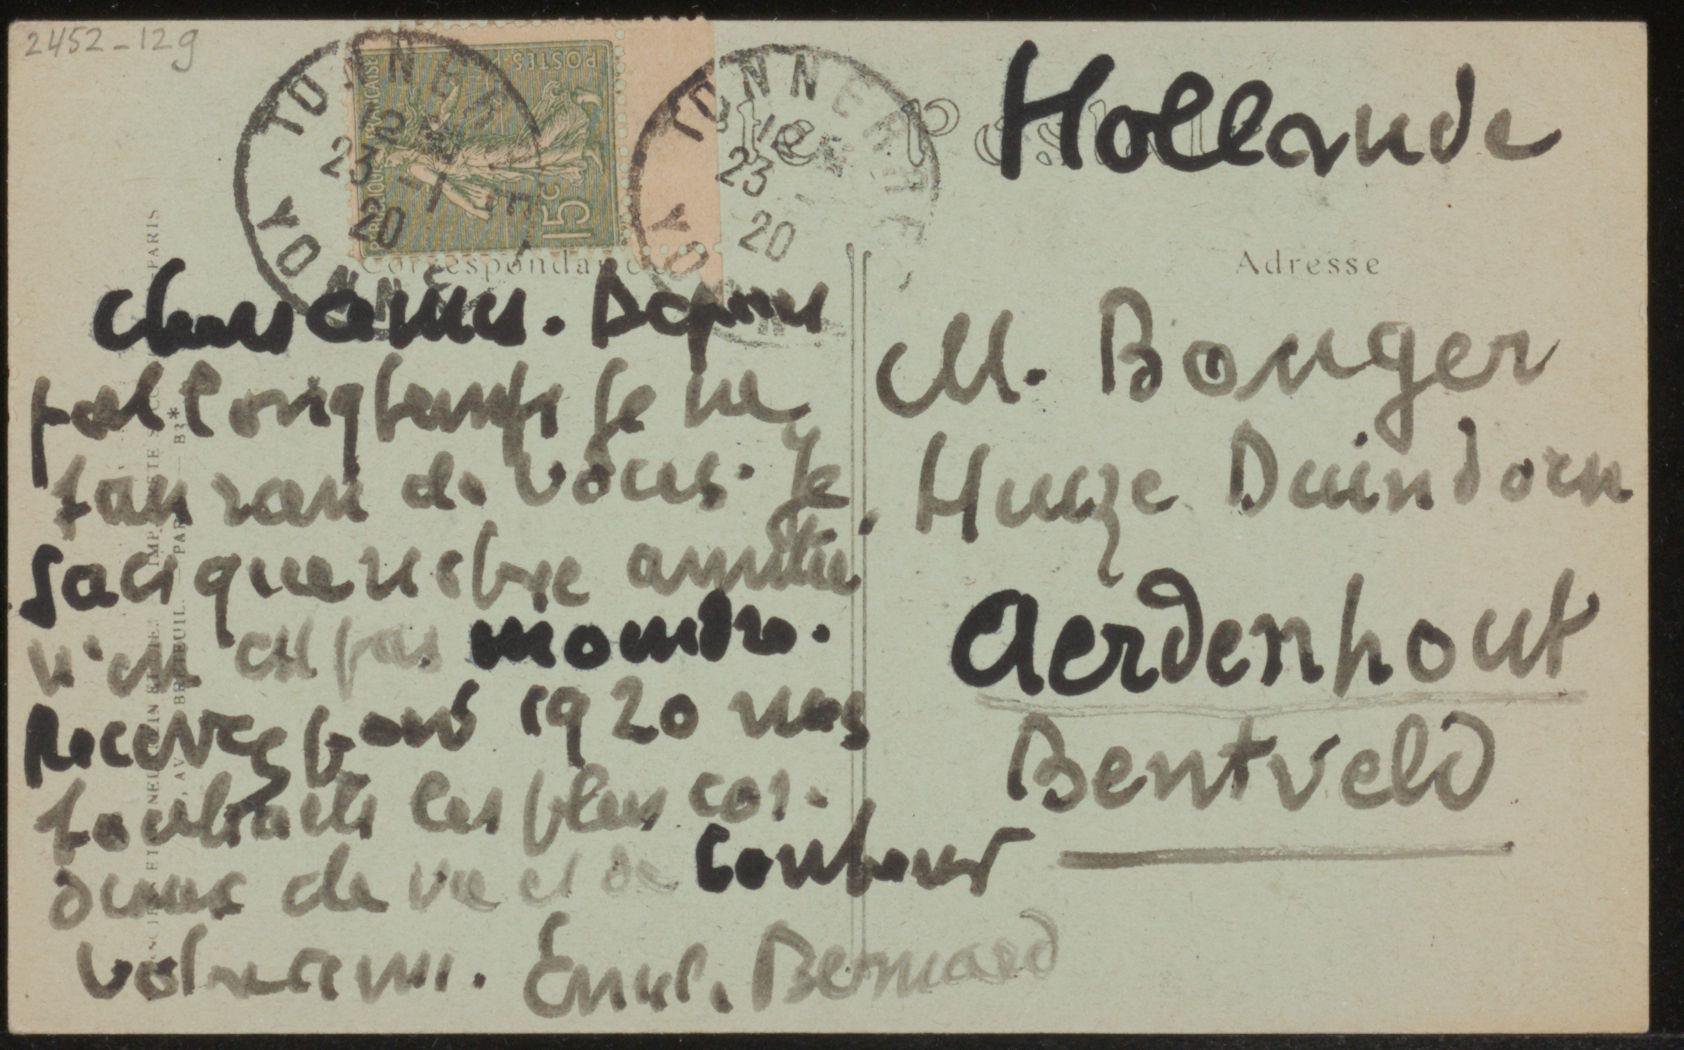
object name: ansichtkaart, prentbriefkaart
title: Prentbriefkaart aan Andries Bonger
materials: cardboard, ink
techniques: photograph, pen, writing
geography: tonnerre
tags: andries bonger